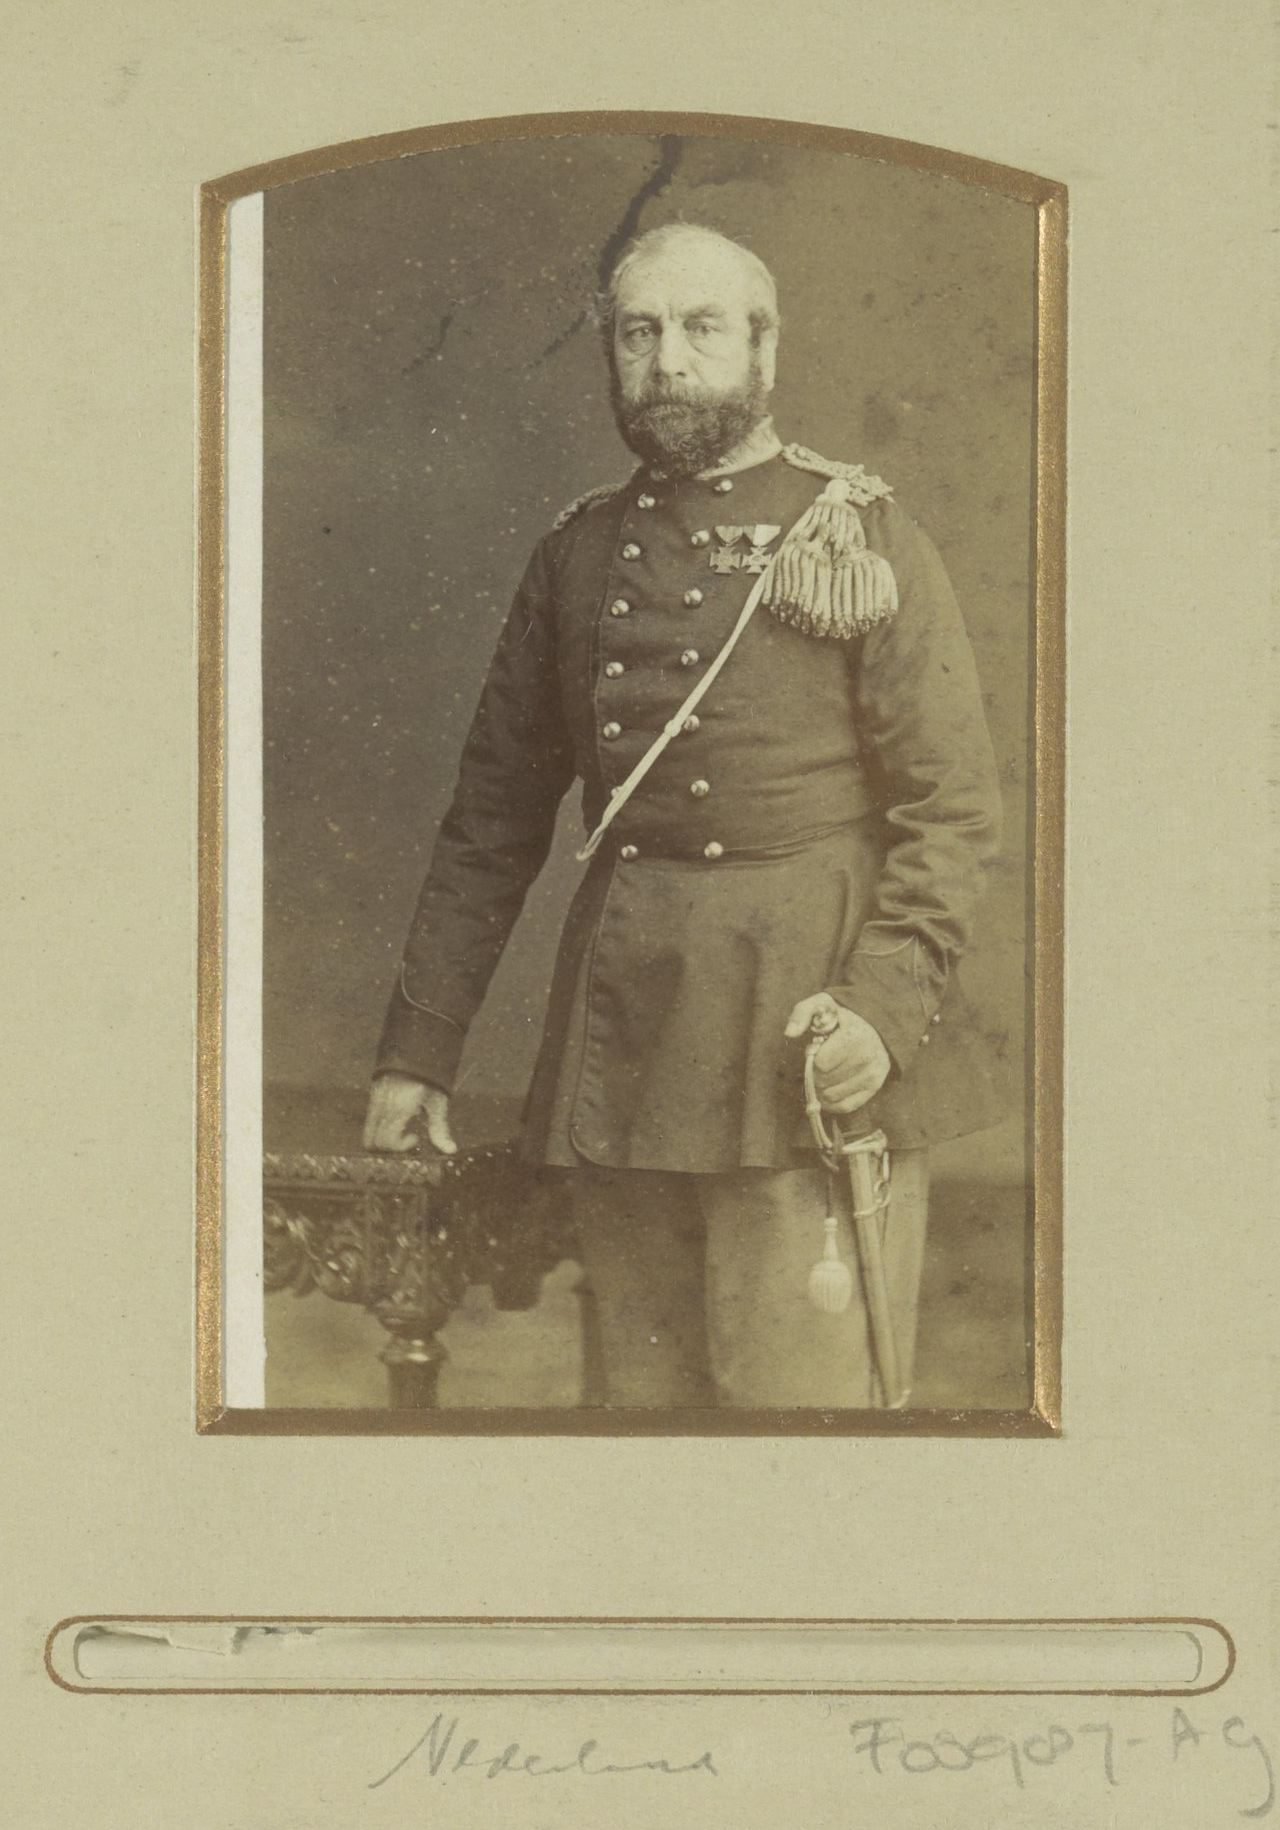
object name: album leaf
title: Portret van een (vermoedelijk) Nederlandse militair, staand bij een tafel met sabel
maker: bernardus bruining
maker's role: fotograaf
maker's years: 1834-1900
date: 1860-1880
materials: cardboard, paper, photographic support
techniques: albumen print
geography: leiden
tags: hacking and thrusting weapons (with name), warfare; military affairs, (military) uniforms, division of armed forces, leiden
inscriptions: address: ‘Leiden’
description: Onderdeel van Album met cartes-de-visite en kabinetfoto's van militairen in uniform.